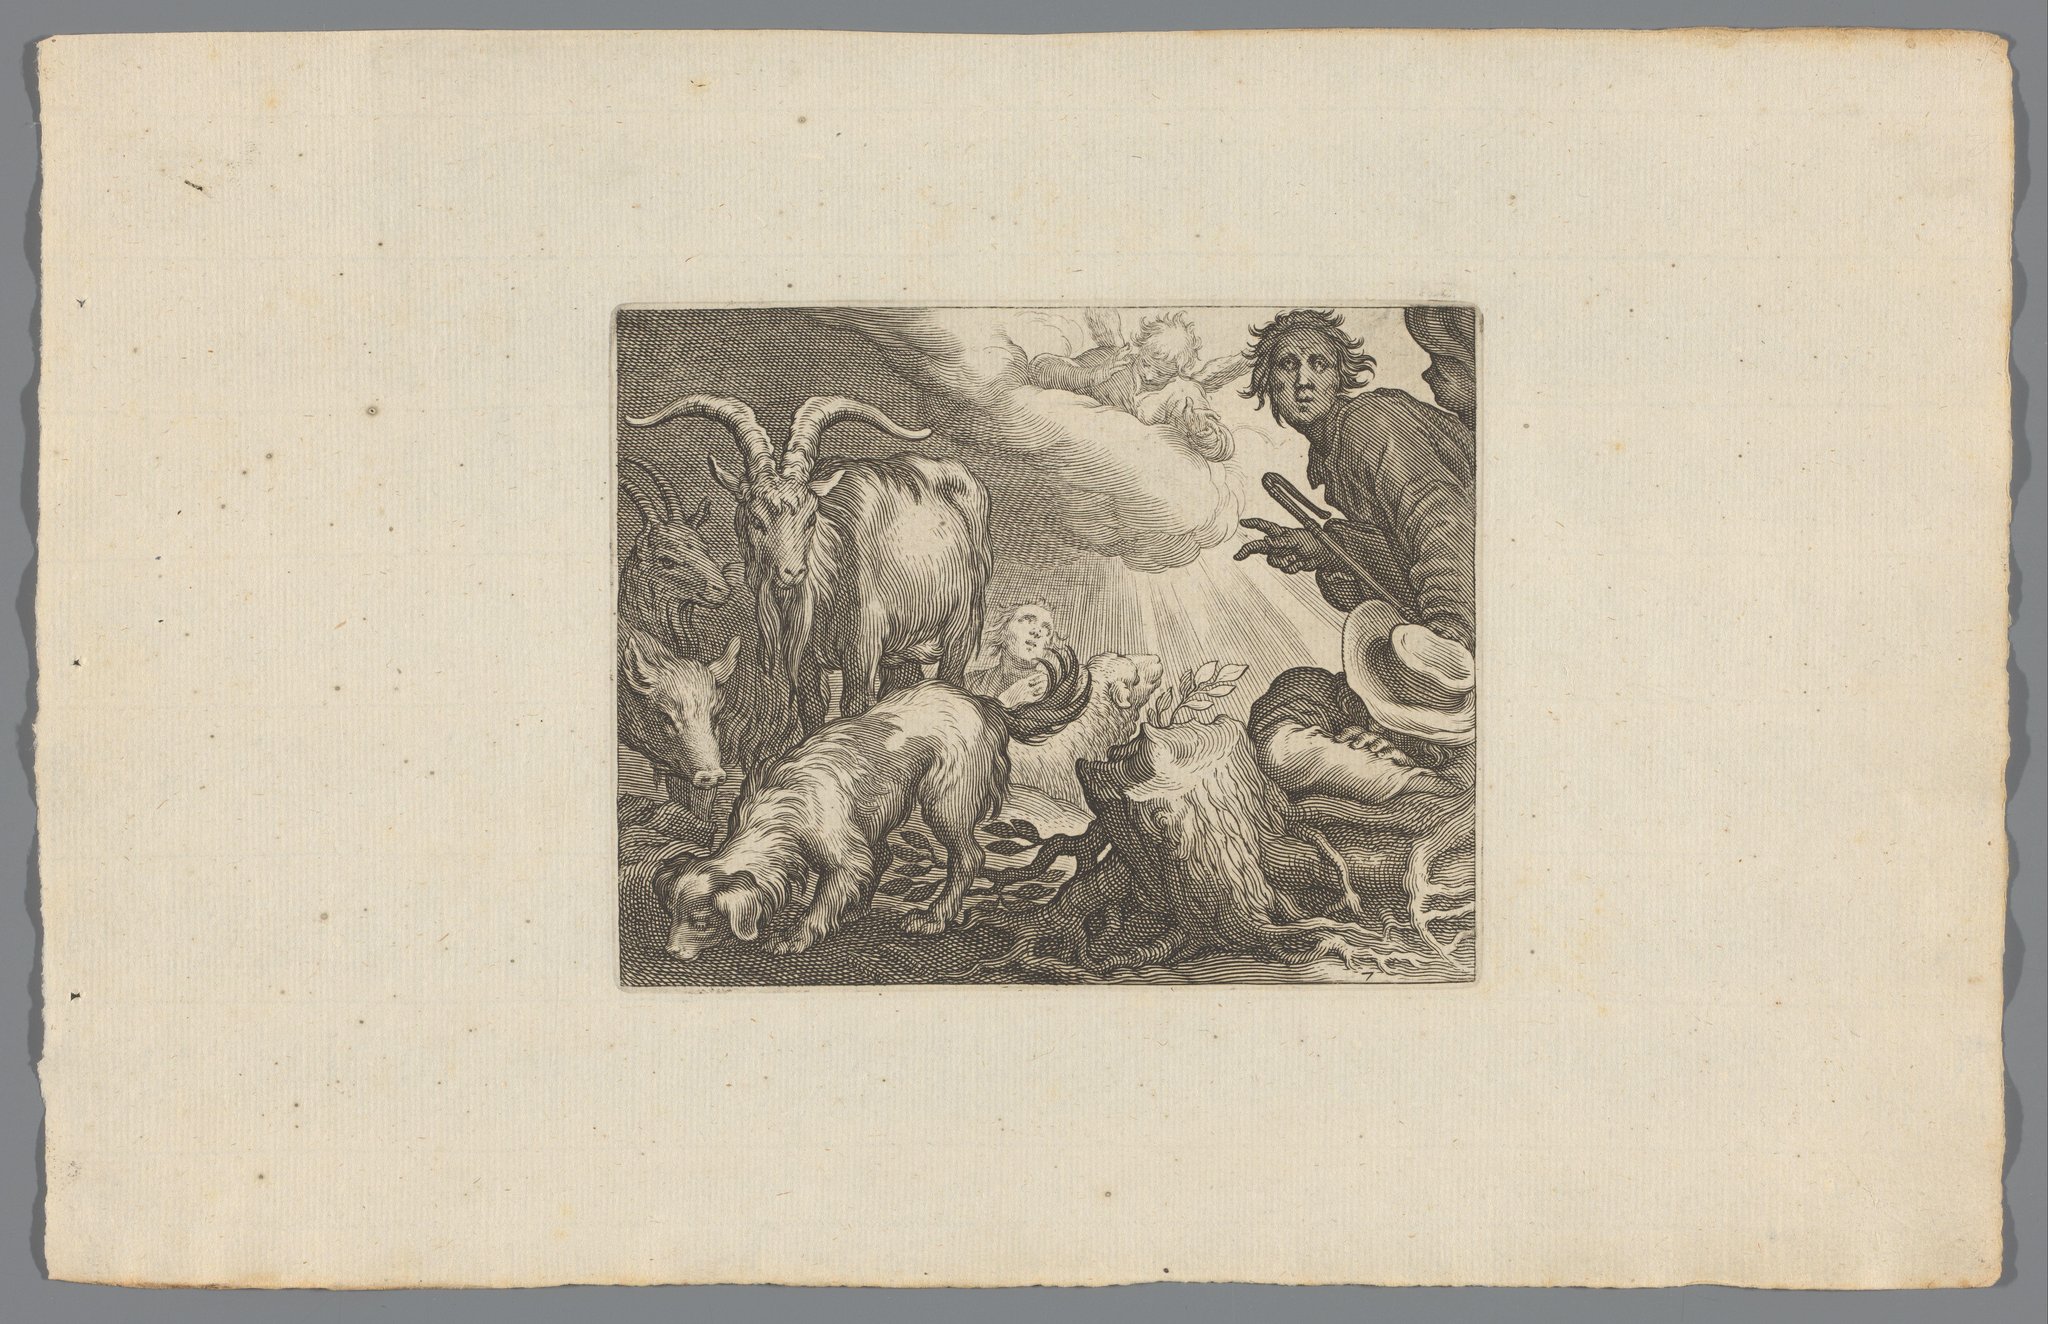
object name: print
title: Pastoralen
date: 1611-1632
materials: paper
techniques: engraving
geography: amsterdam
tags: annunciation of christ's birth to the shepherds (and/or shepherdesses) at night; a host of singing angels in the air, goat, dog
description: Prent maakt deel uit van een serie van veertien prenten.